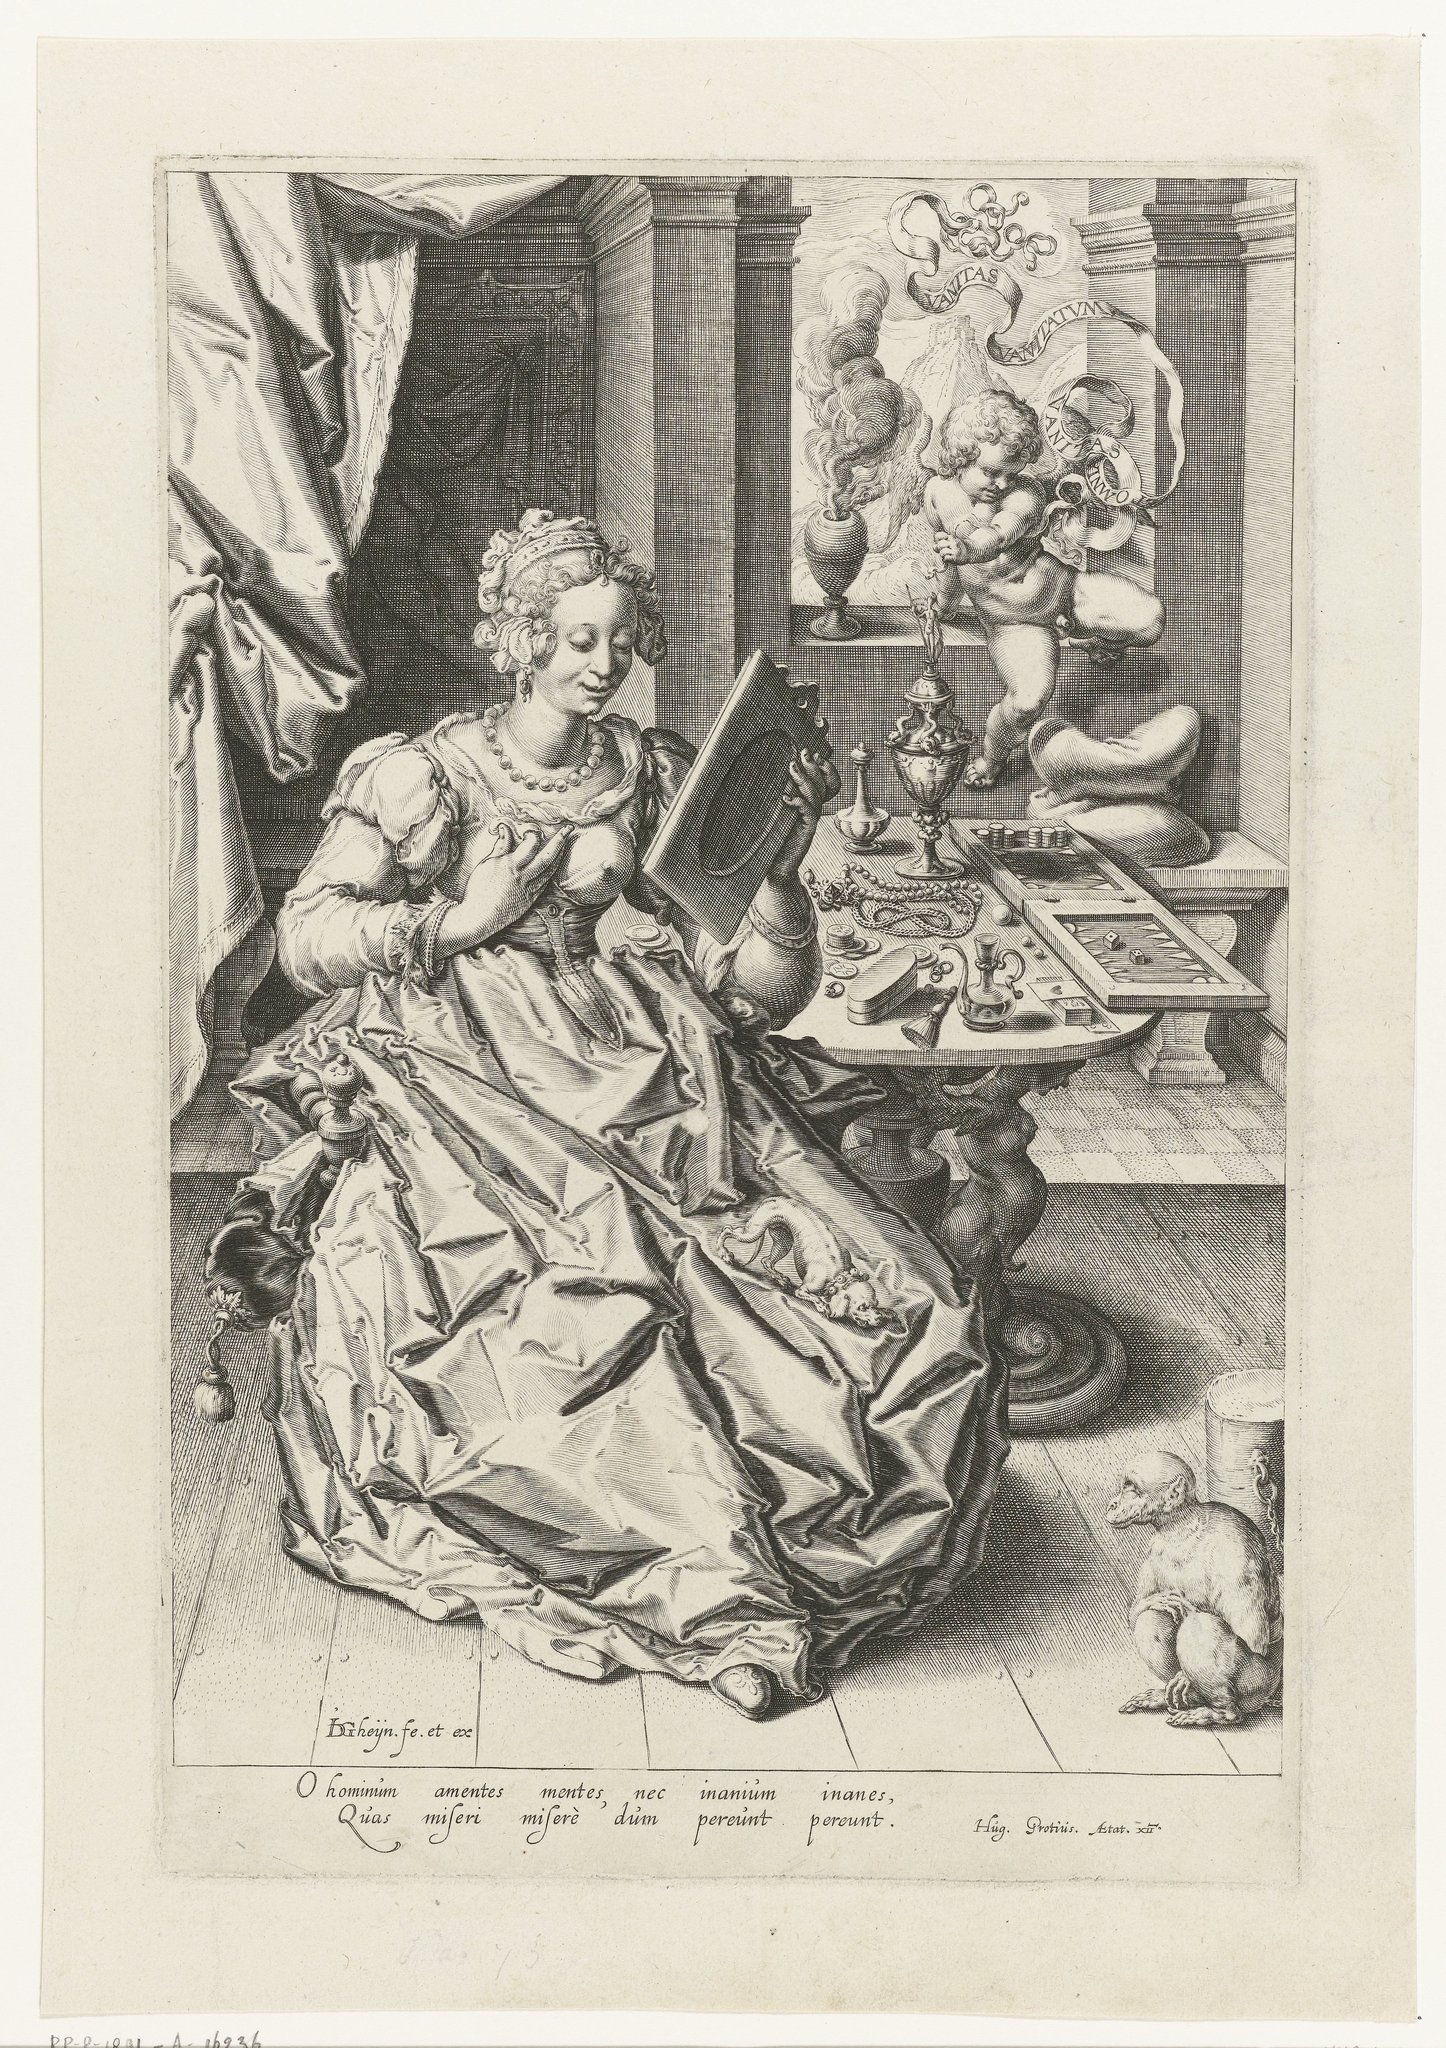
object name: print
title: Allegorie op de ijdelheid (jongedame met spiegel en putto)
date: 1595-1596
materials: paper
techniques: engraving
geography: netherlands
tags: scenes symbolizing 'vanitas', 'vanitas' symbols, backgammon, tric-trac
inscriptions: collector's mark: Lugt 2228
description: Vanitasvoorstelling in de vorm van een vrouw, gehuld in kostbare kleding, zichzelf bewonderend in een handspiegel, op haar schoot een hondje, aan haar voeten een aapje. Op de tafel naast haar sieraden en een bordspel. Door het raam achter de dame klimt een putto naar binnen met een banderol waarop staat 'VANITAS VANITATUM, EST OMNIA VANITAS'. Onder de voorstelling twee regels tekst in Latijn.